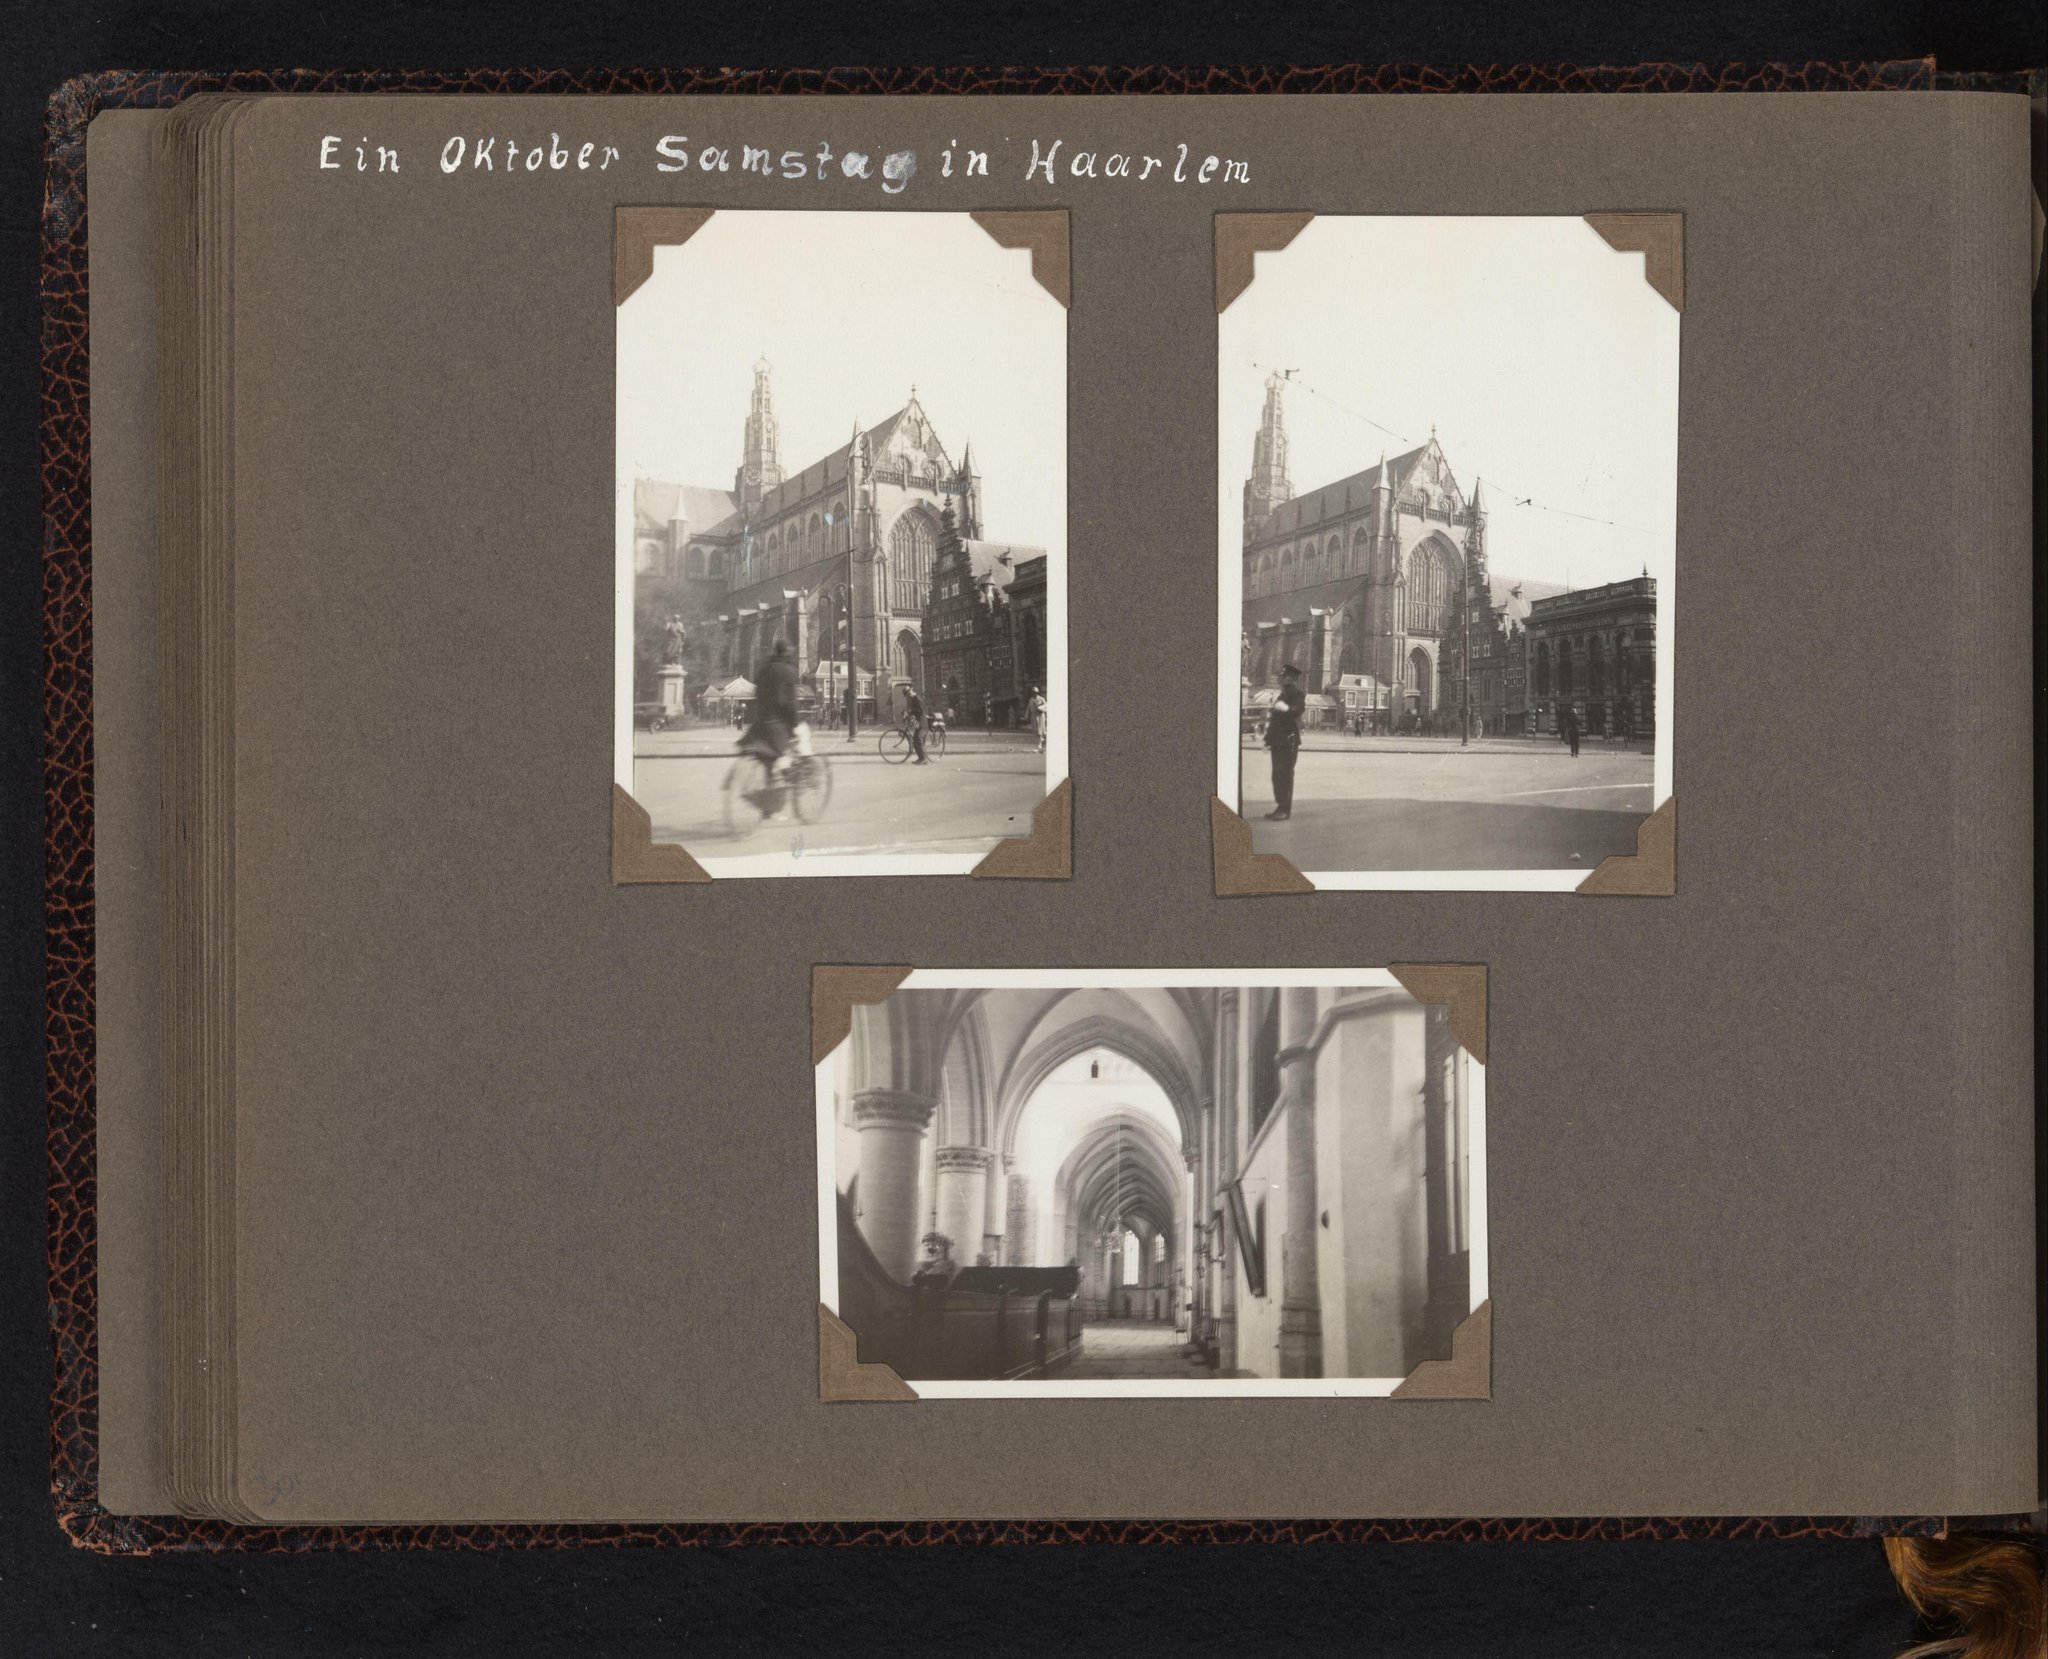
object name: photograph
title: Bezoek aan de Sint-Bavokerk te Haarlem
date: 1910-1930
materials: cardboard, paper, photographic support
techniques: gelatin silver print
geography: haarlem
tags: church (exterior), interior of church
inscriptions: annotation: ‘Ein Oktober Samstag in Haarlem’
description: Drie foto's van de Sint-Bavokerk te Haarlem. Deze pagina maakt deel uit van een album.